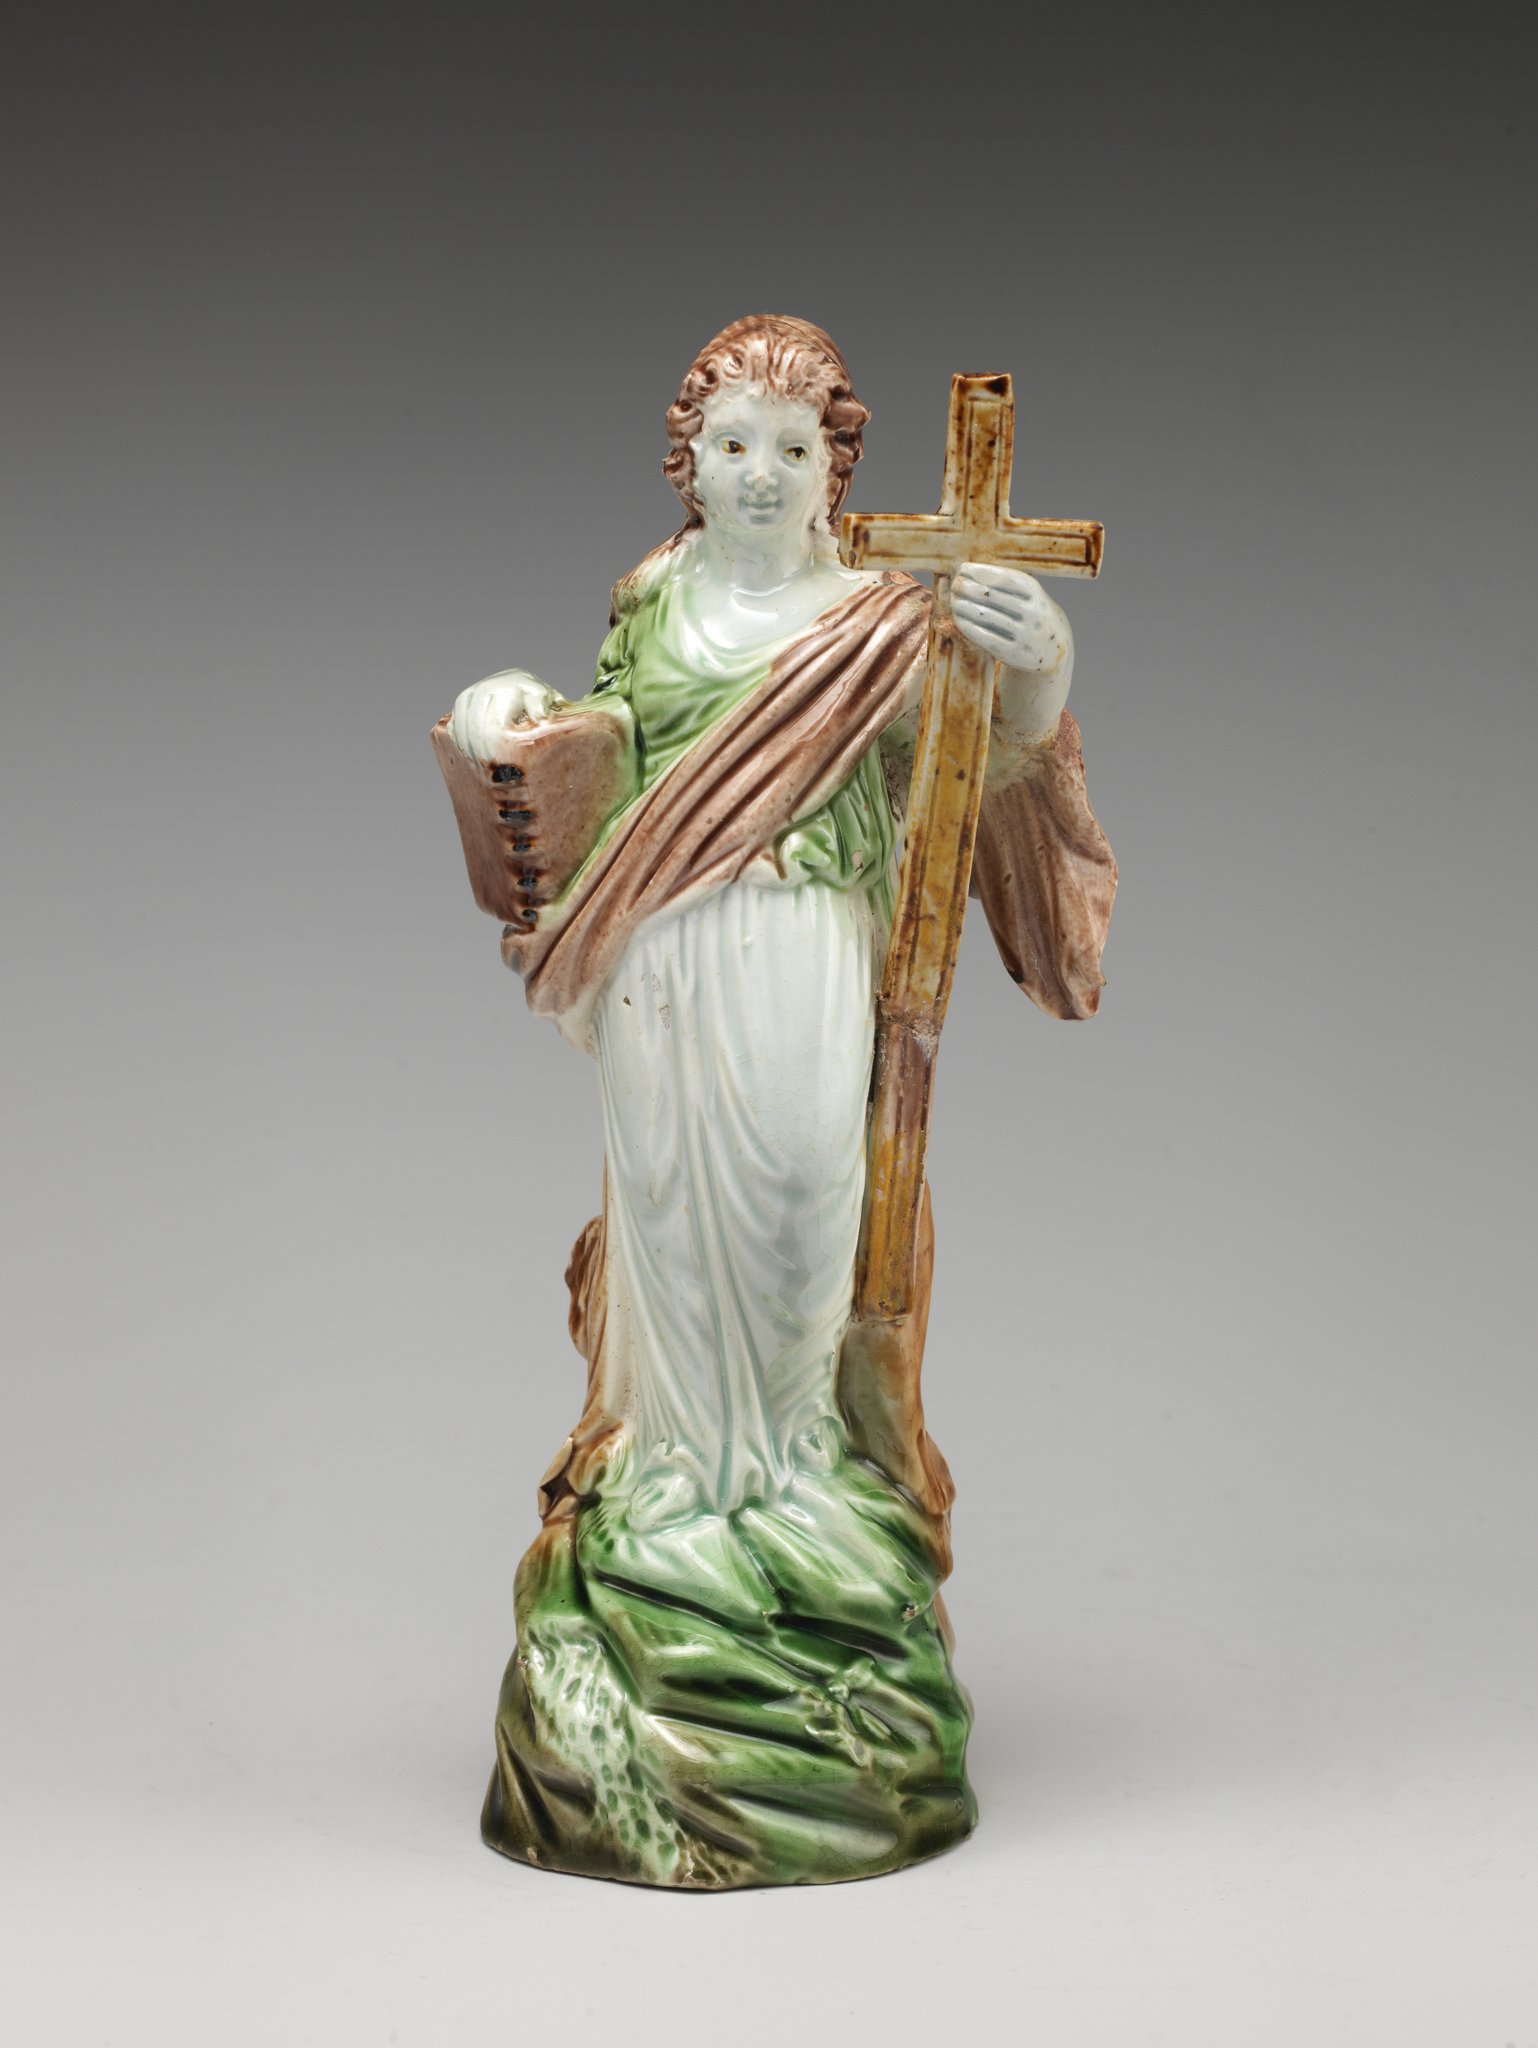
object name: figure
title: Faith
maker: ralph wood the elder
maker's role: maker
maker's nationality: british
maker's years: 1715-1772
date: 1770-1780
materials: earthenware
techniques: glazing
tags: women,cross